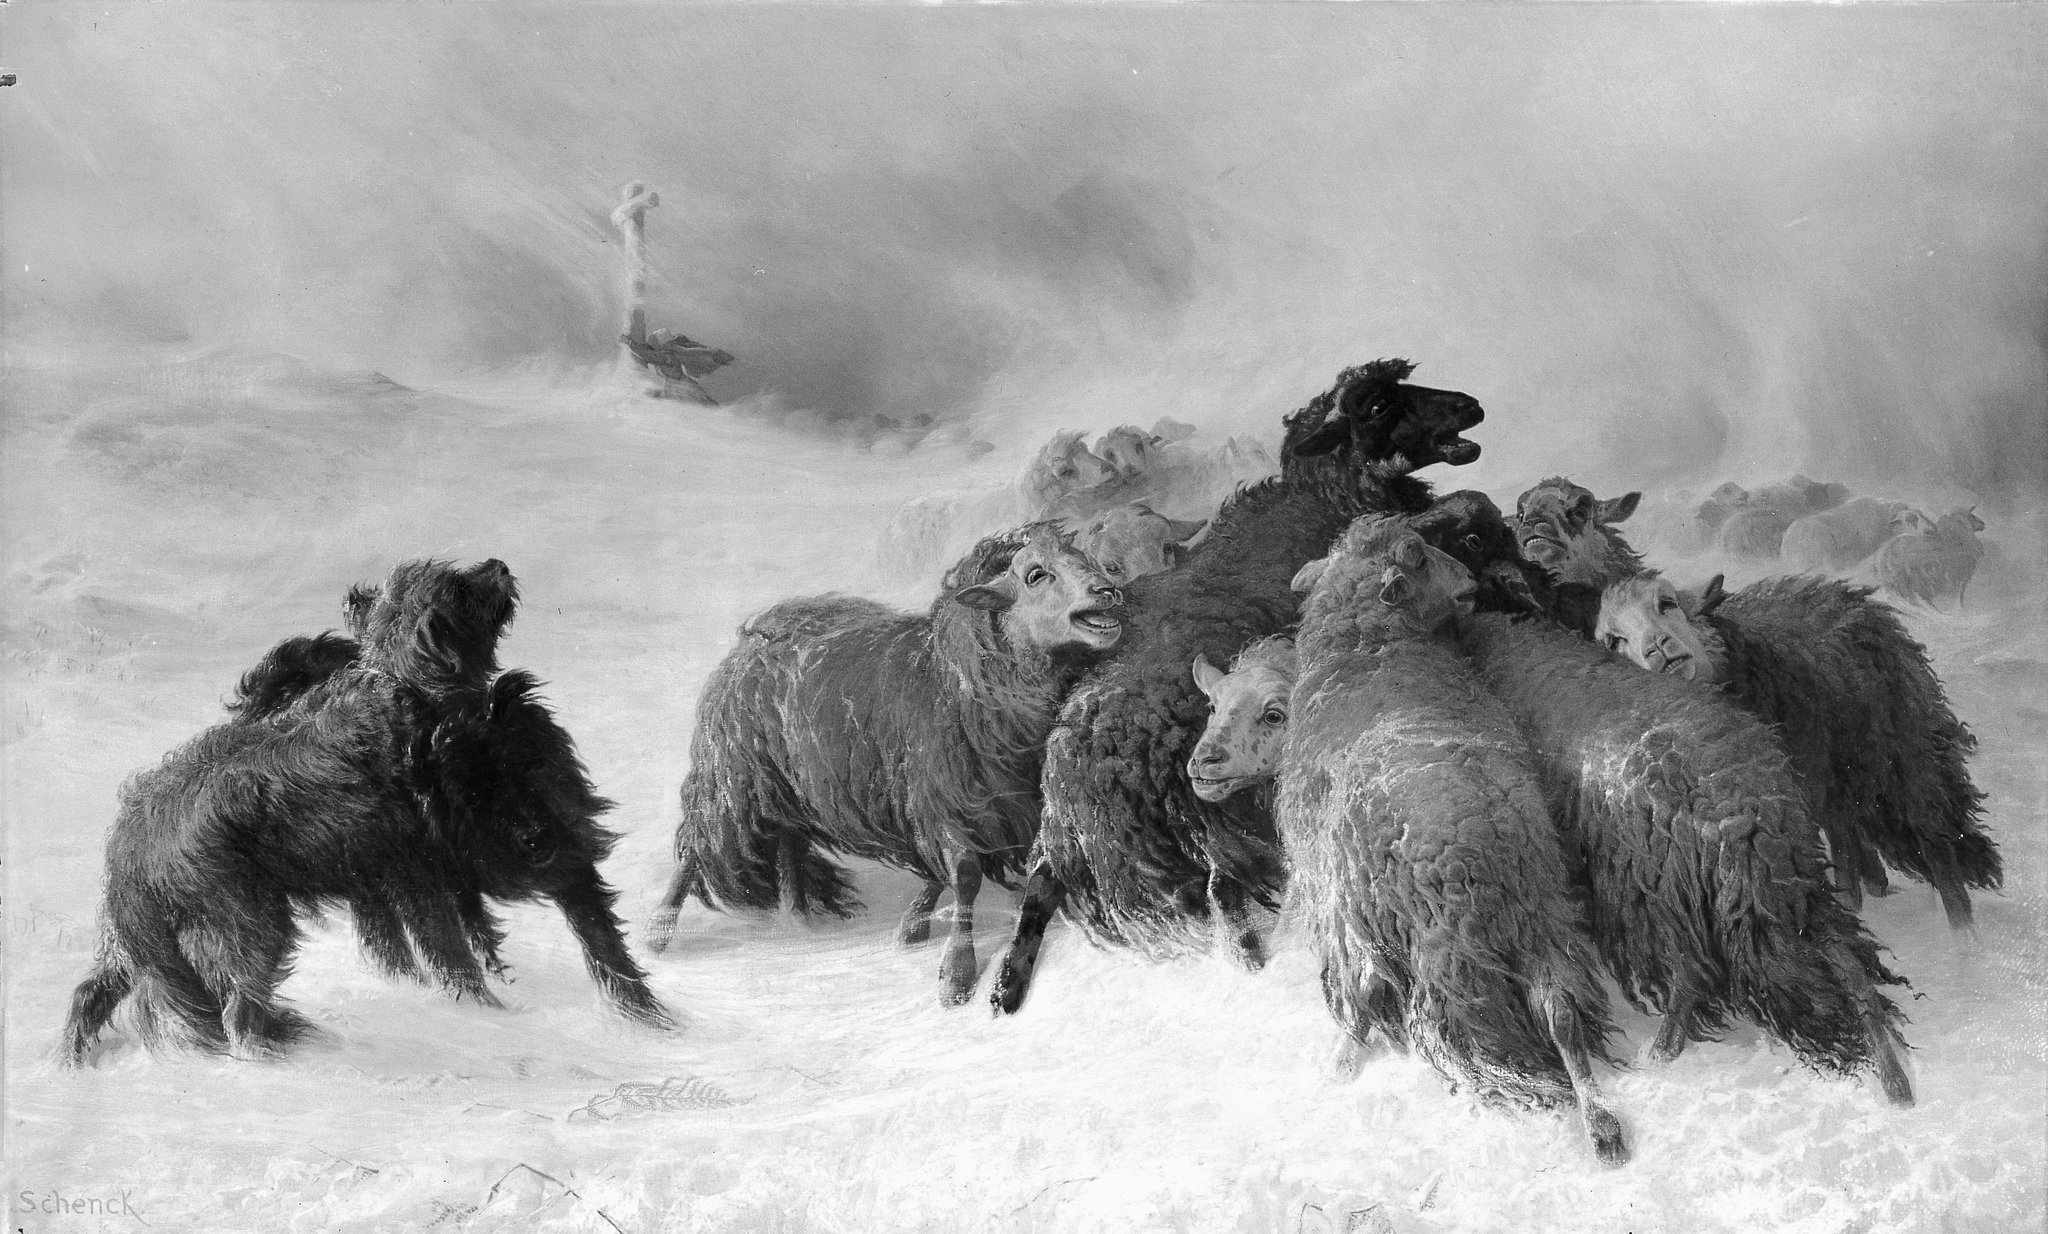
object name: painting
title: Lost: Souvenir of Auvergne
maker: august friedrich albrecht schenck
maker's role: artist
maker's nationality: danish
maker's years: 1828-1901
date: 1848-1901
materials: canvas, oil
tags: sheep